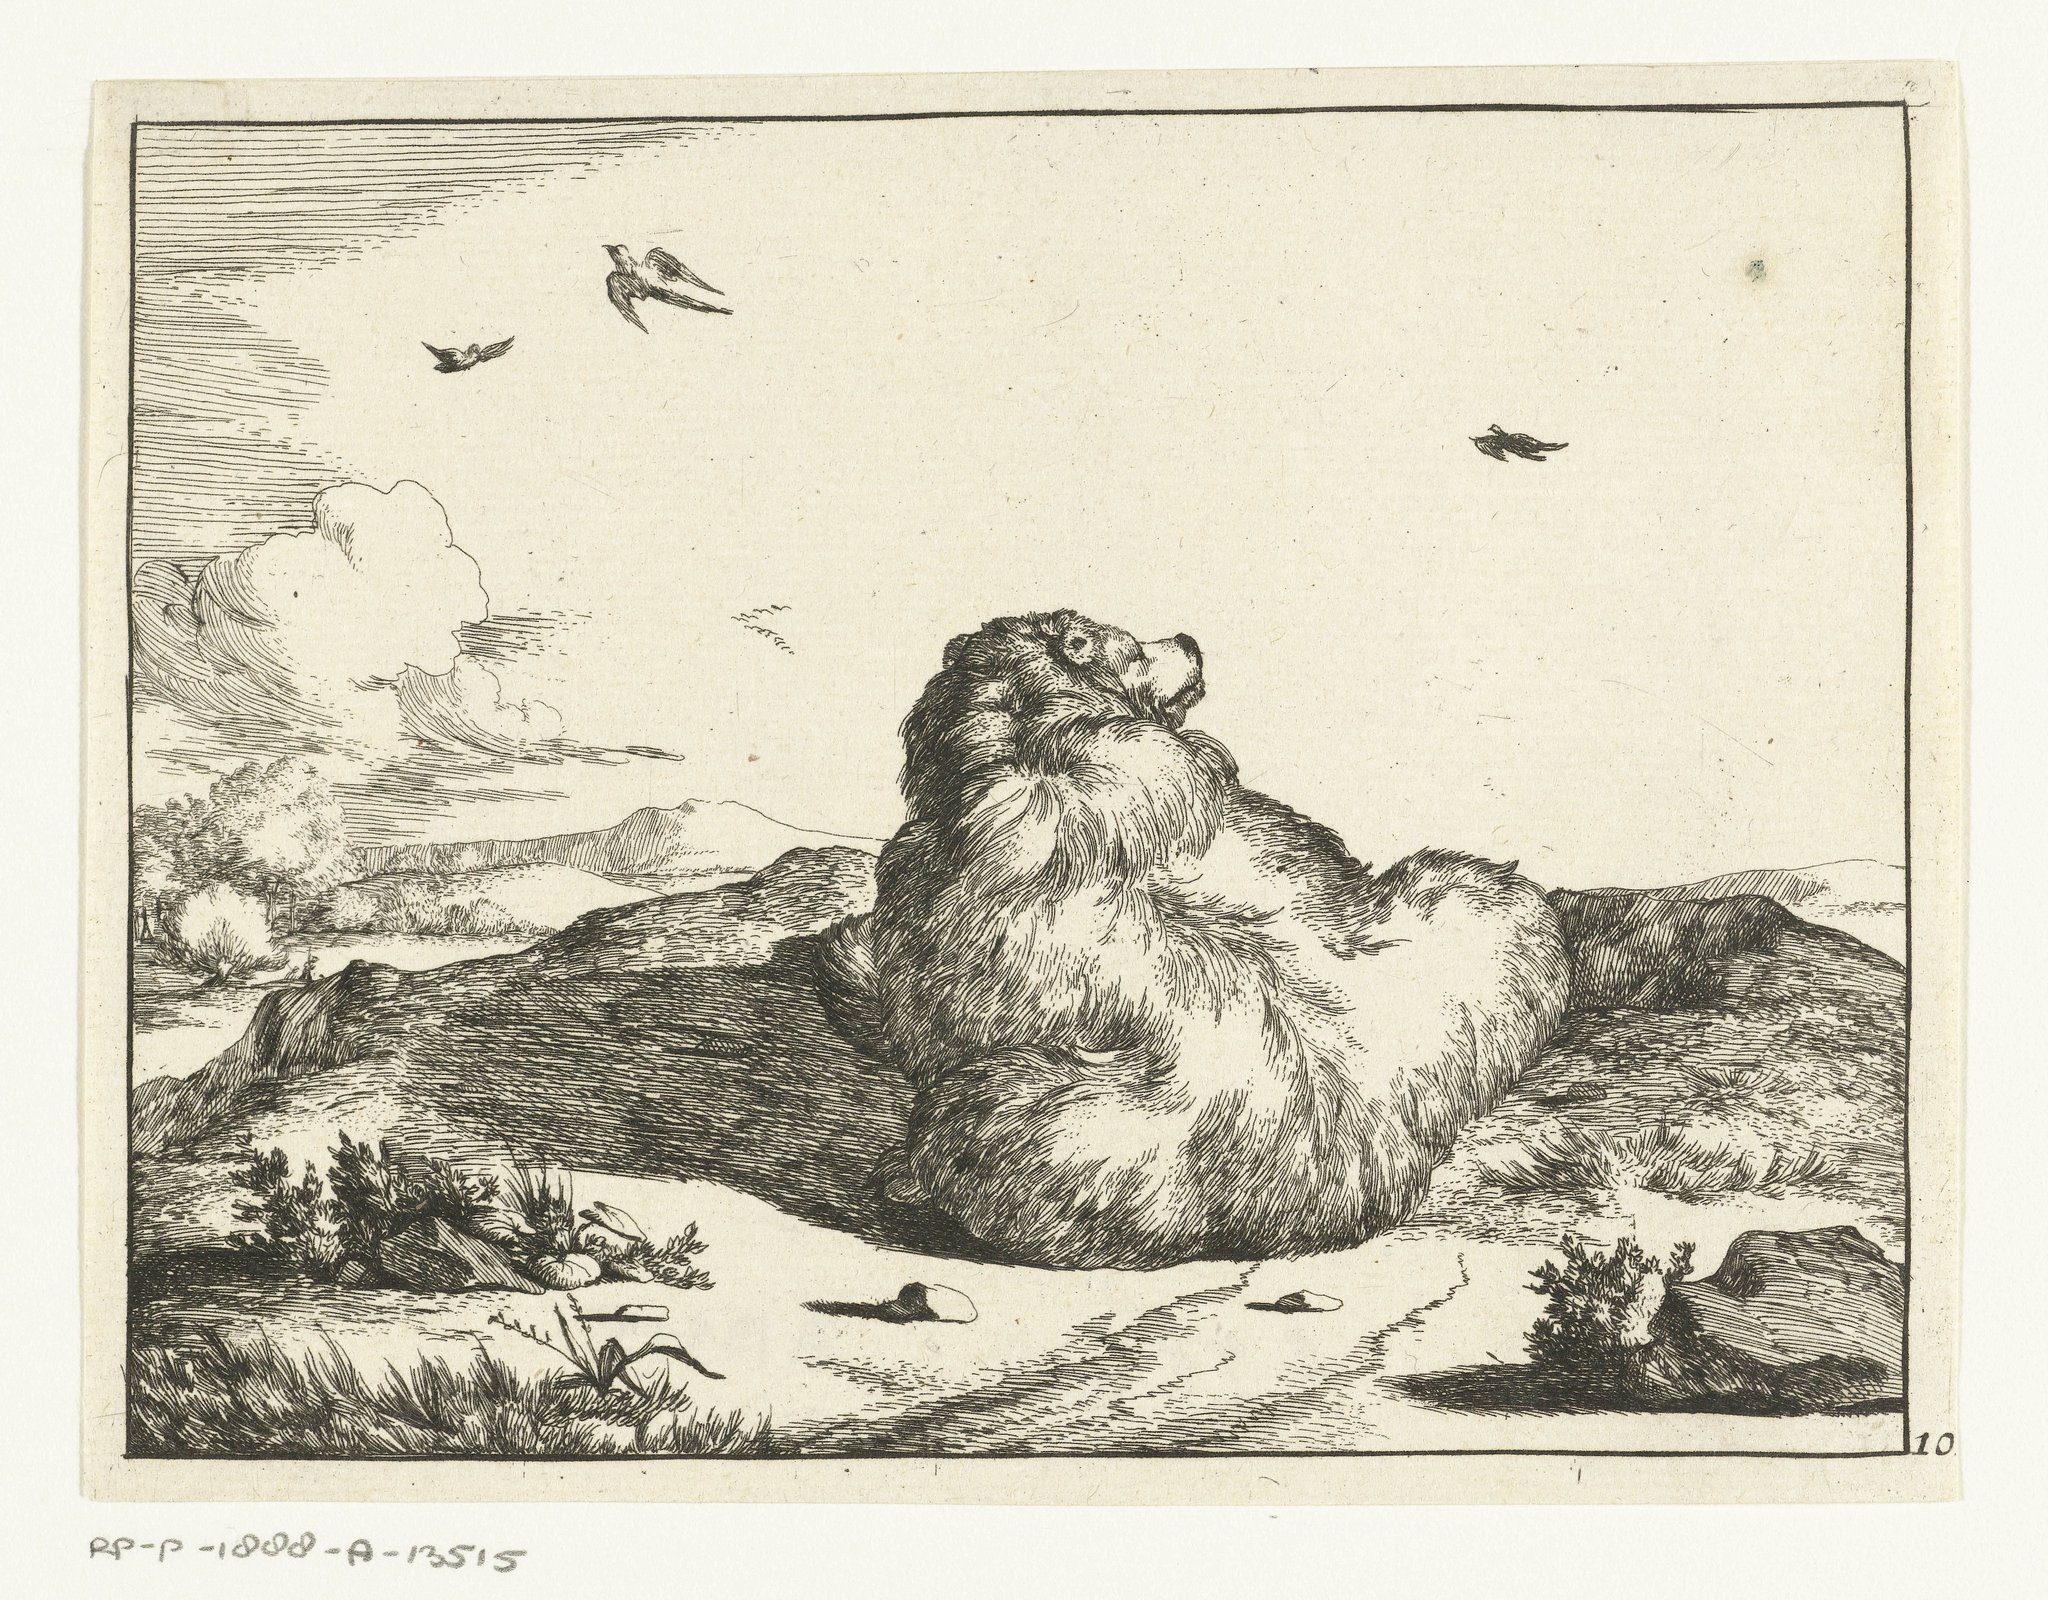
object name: print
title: Beren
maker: marcus de bye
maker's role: print maker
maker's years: 1639-1688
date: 1664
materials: paper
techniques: etching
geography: the hague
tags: beasts of prey, predatory animals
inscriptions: collector's mark: Lugt 2228